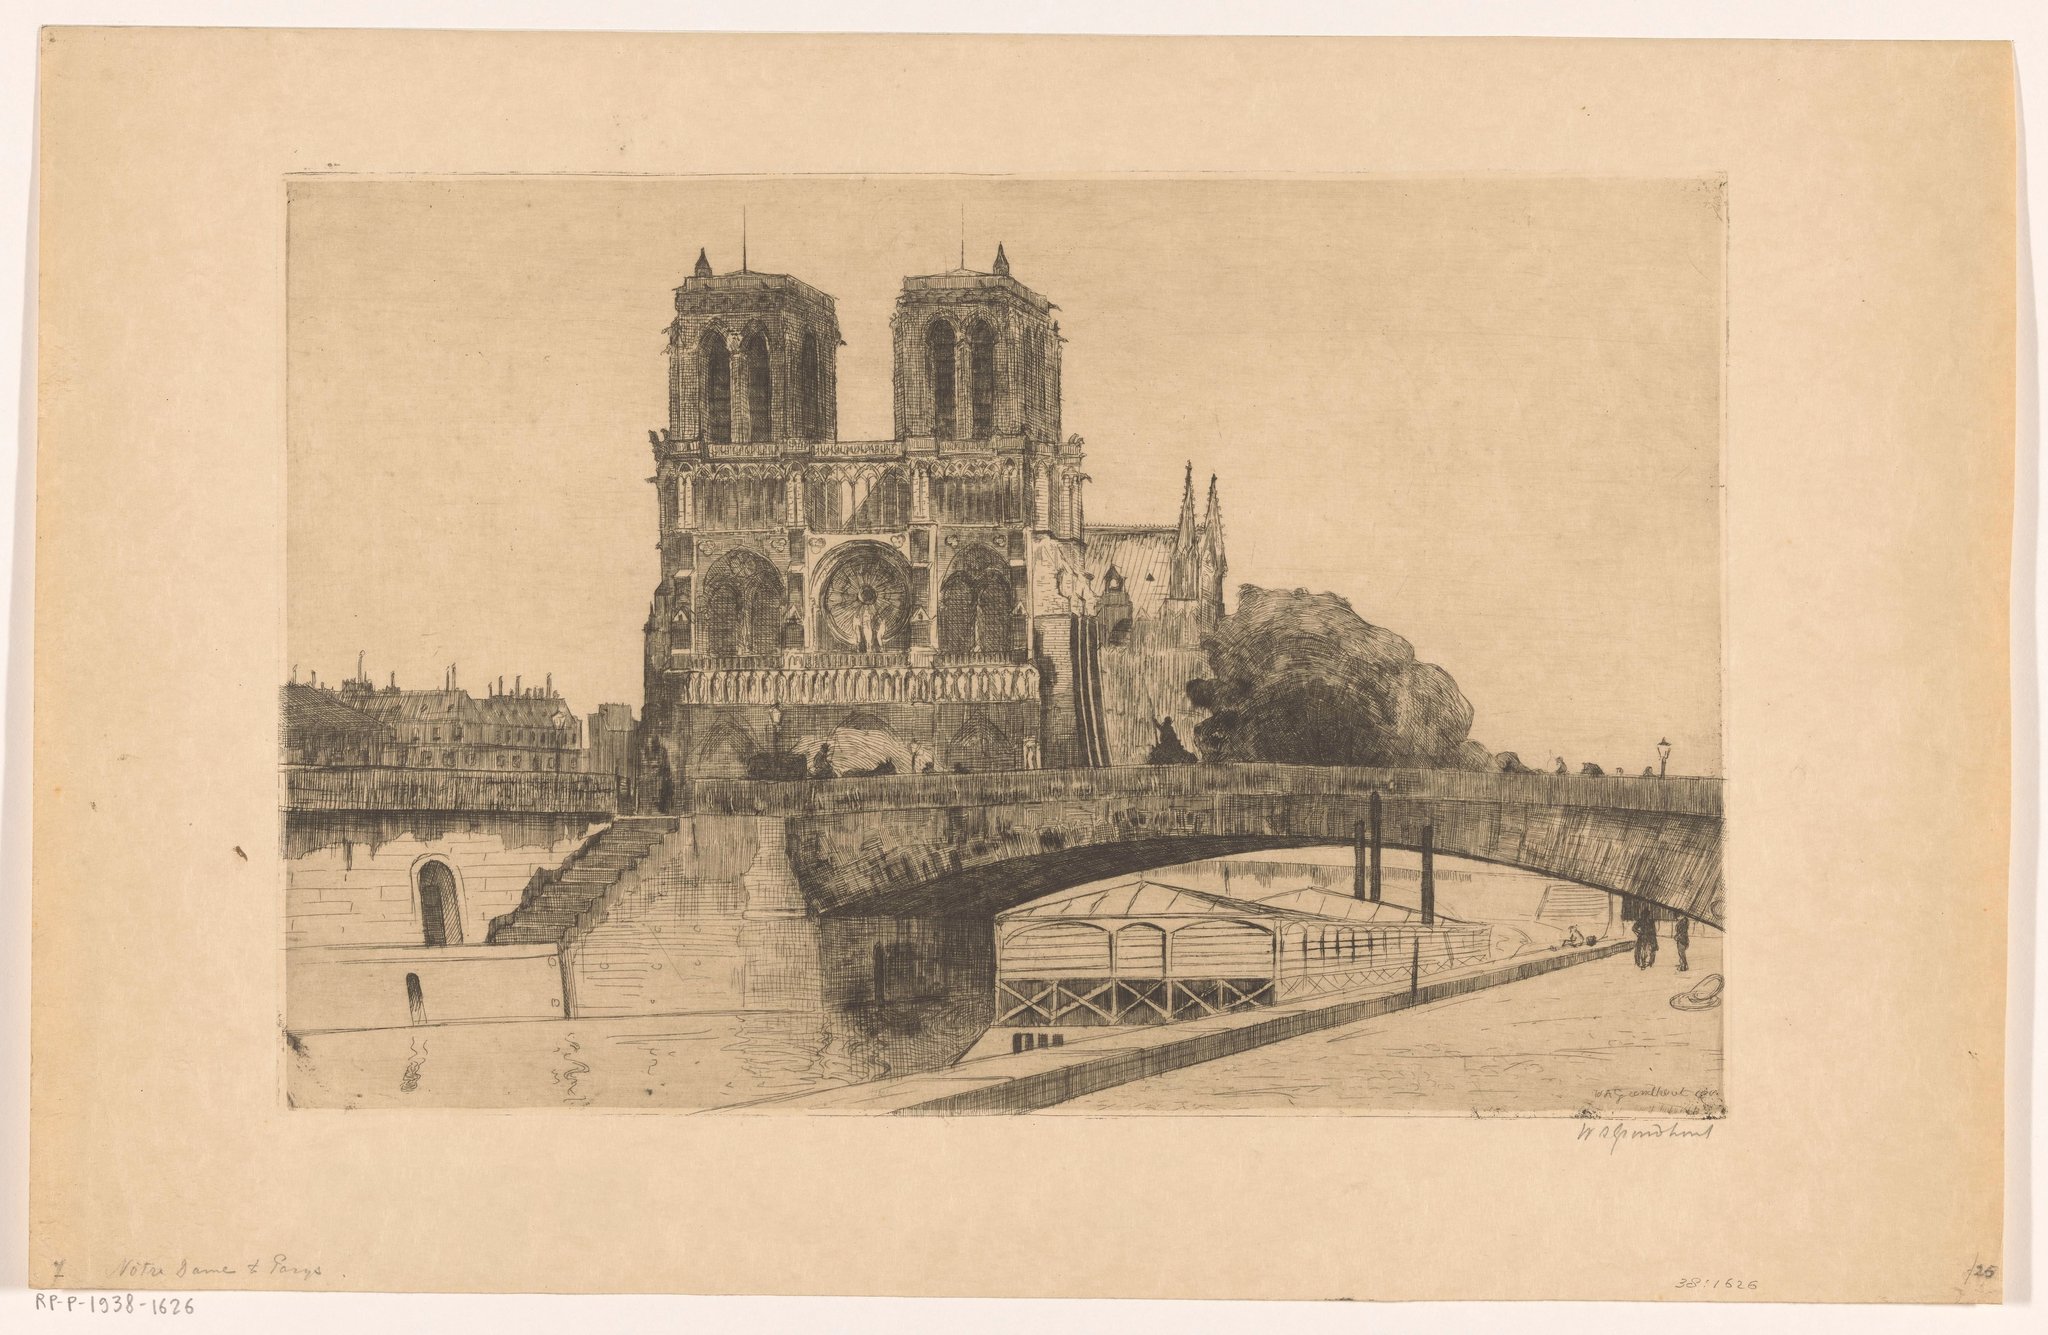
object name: print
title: Notre-Dame, Paris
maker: willem adrianus grondhout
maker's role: draughtsman, painter, print maker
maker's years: 1878-1934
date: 1888-1934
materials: paper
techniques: etching, intaglio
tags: church (exterior), bridge in city across river, canal, etc., quay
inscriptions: collector's mark: Lugt 2228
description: De Notre-Dame in Parijs, gezien vanaf de Quai de Montebello. Op de voorgrond de Seine die onder de Pont au Double stroomt.